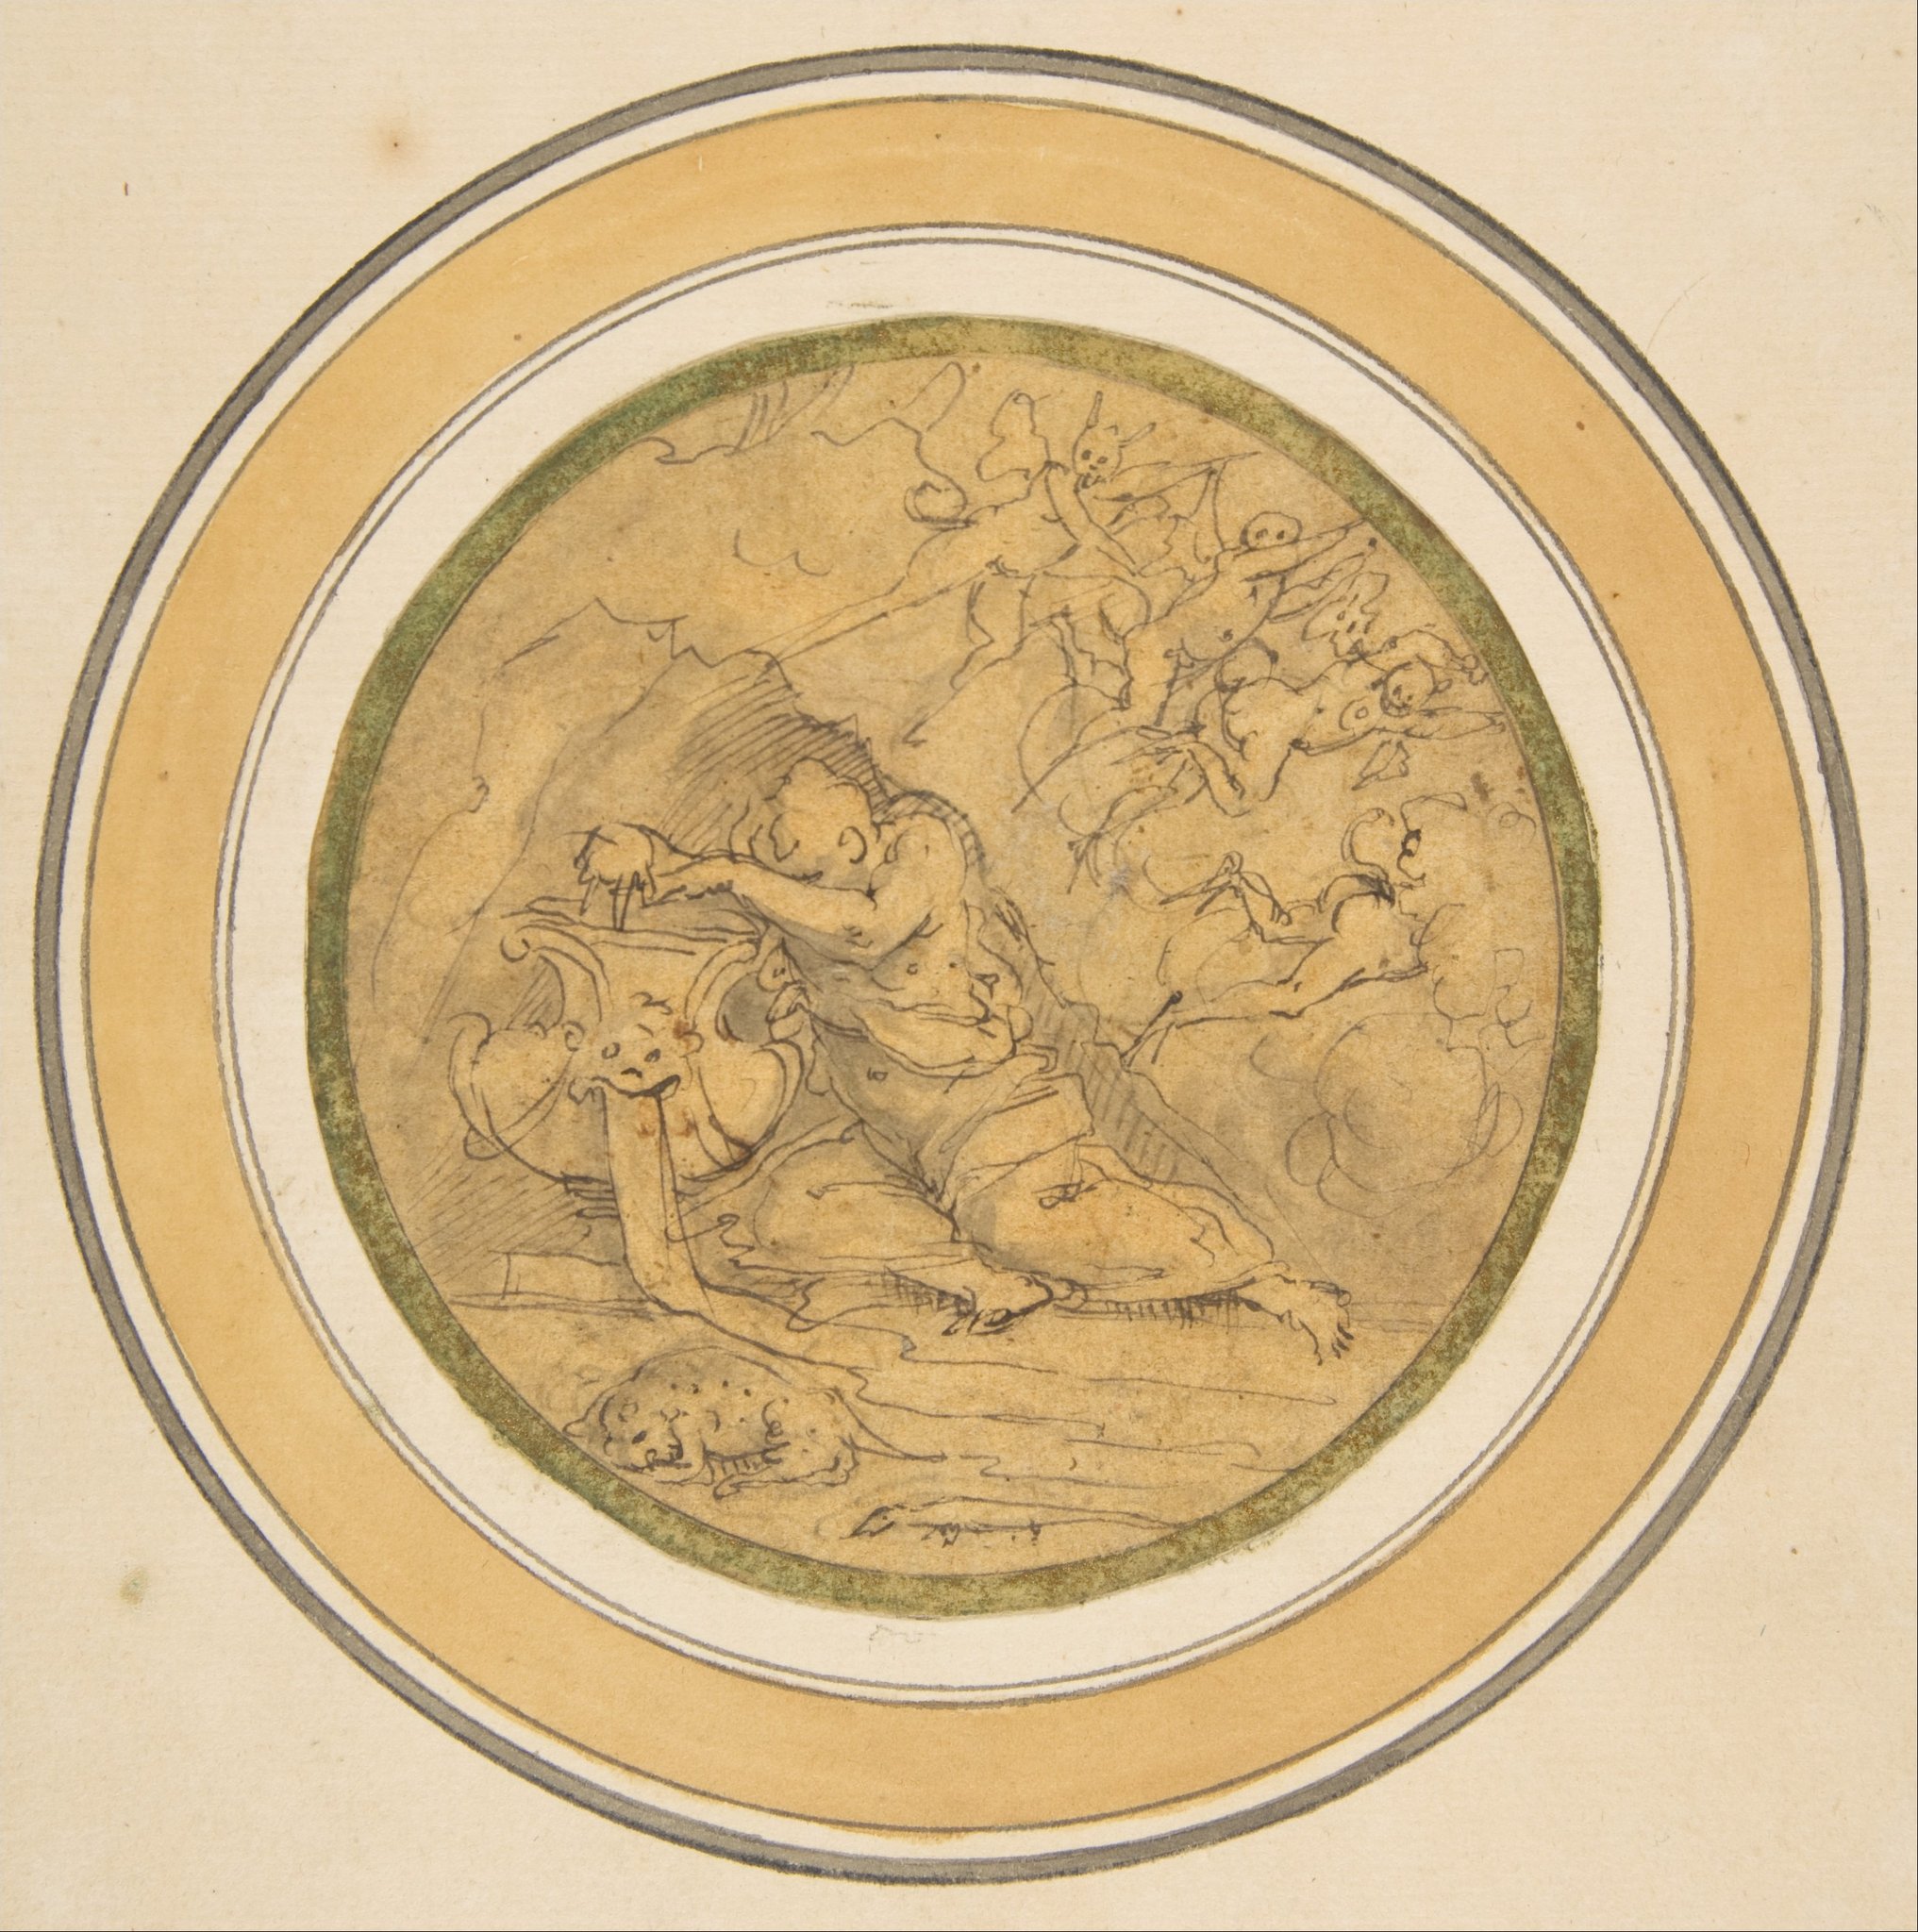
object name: drawing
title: Allegory of Forgetfulness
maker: giorgio vasari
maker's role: artist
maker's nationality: italian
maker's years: 1511-1574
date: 1570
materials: chalk, ink, paper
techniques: brush, pen, wash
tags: women